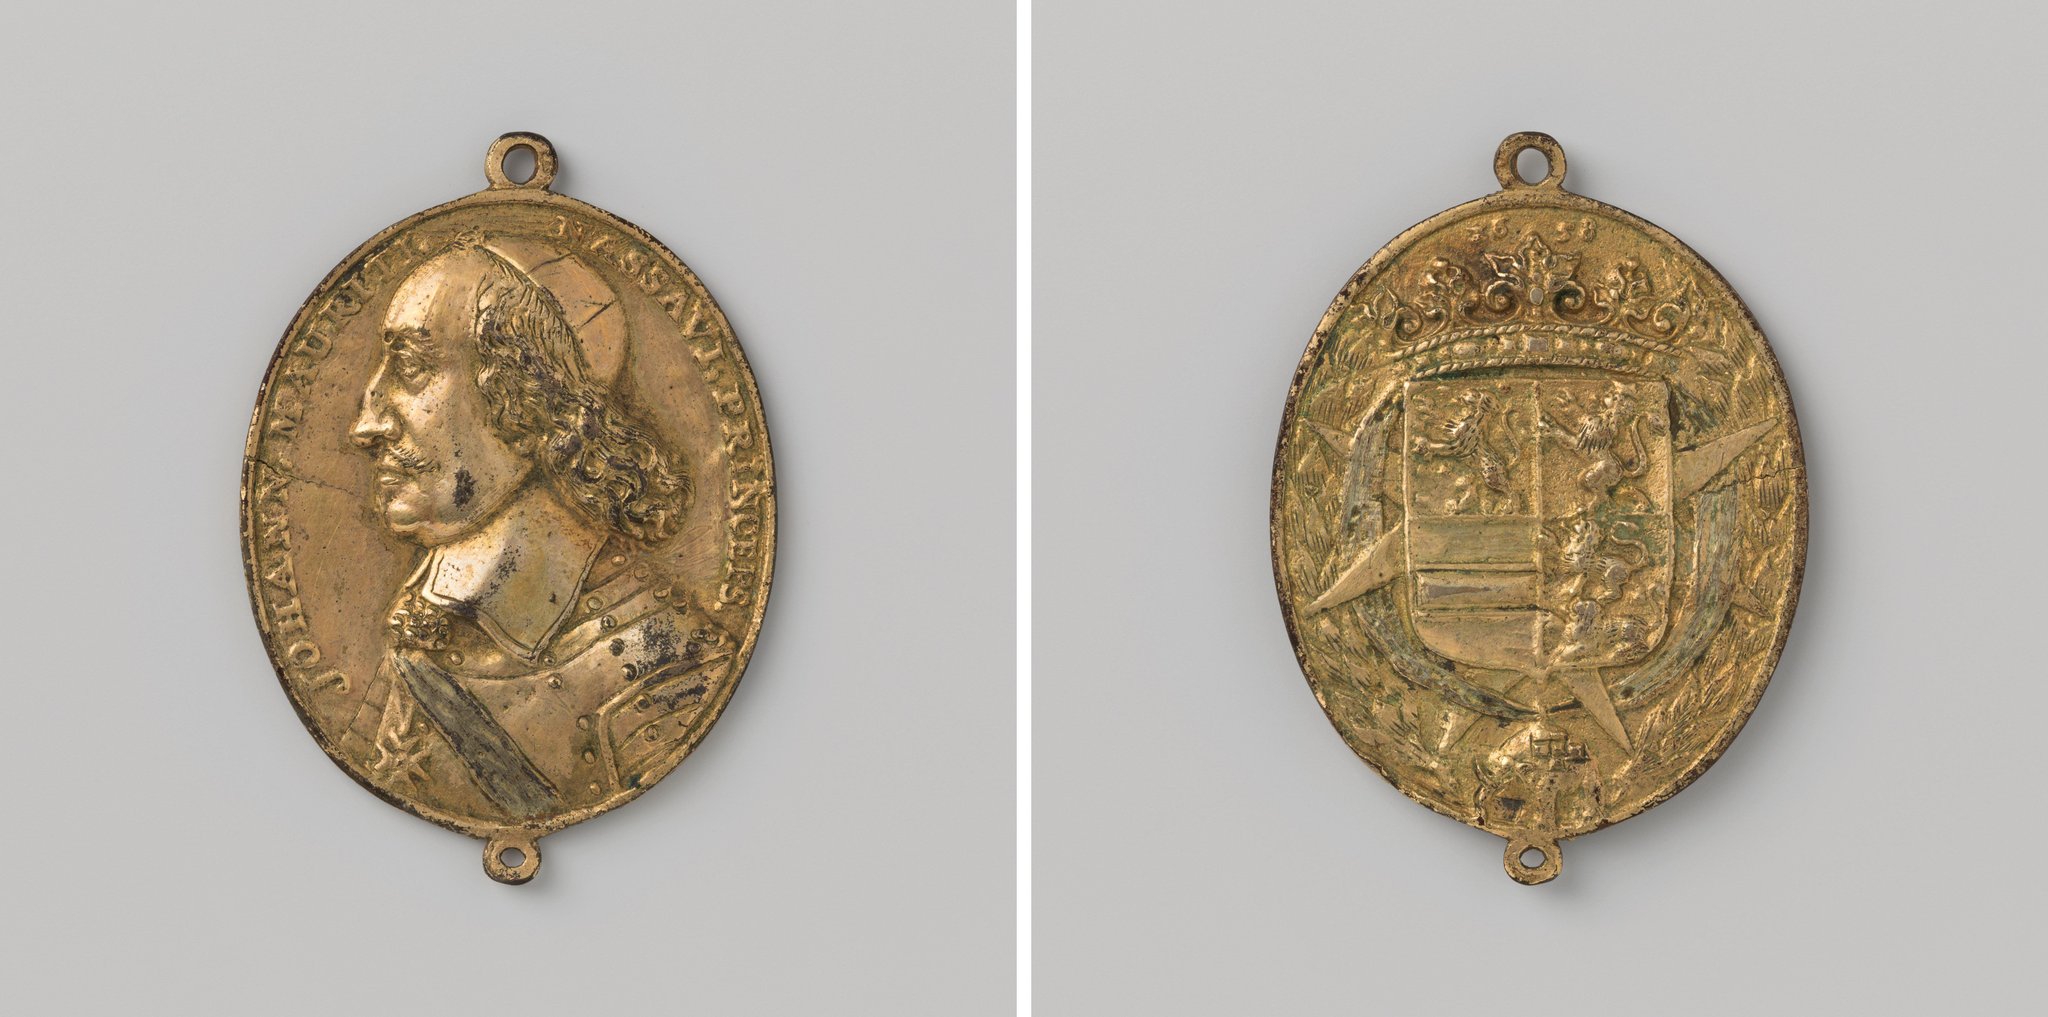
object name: history medal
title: Johan Maurits van Nassau, gouverneur van Brazilie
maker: Anonymous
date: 1658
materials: metal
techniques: gilding, striking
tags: earl, johan maurits graaf van nassau-siegen, brasil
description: ovale penning met aan onder- en bovenzijde draagoog. Voorzijde: borststuk man binnen omschrift. Keerzijde: gekroond wapenschild, omgeven door zes punten van ster, omhangen met orde van olifant binnen lauwerkrans